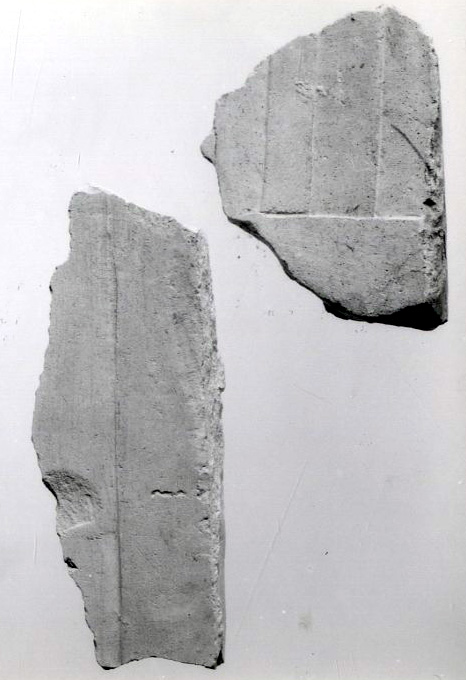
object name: relief fragment, tomb of meketre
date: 1981-1975 BCE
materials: limestone, paint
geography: egypt